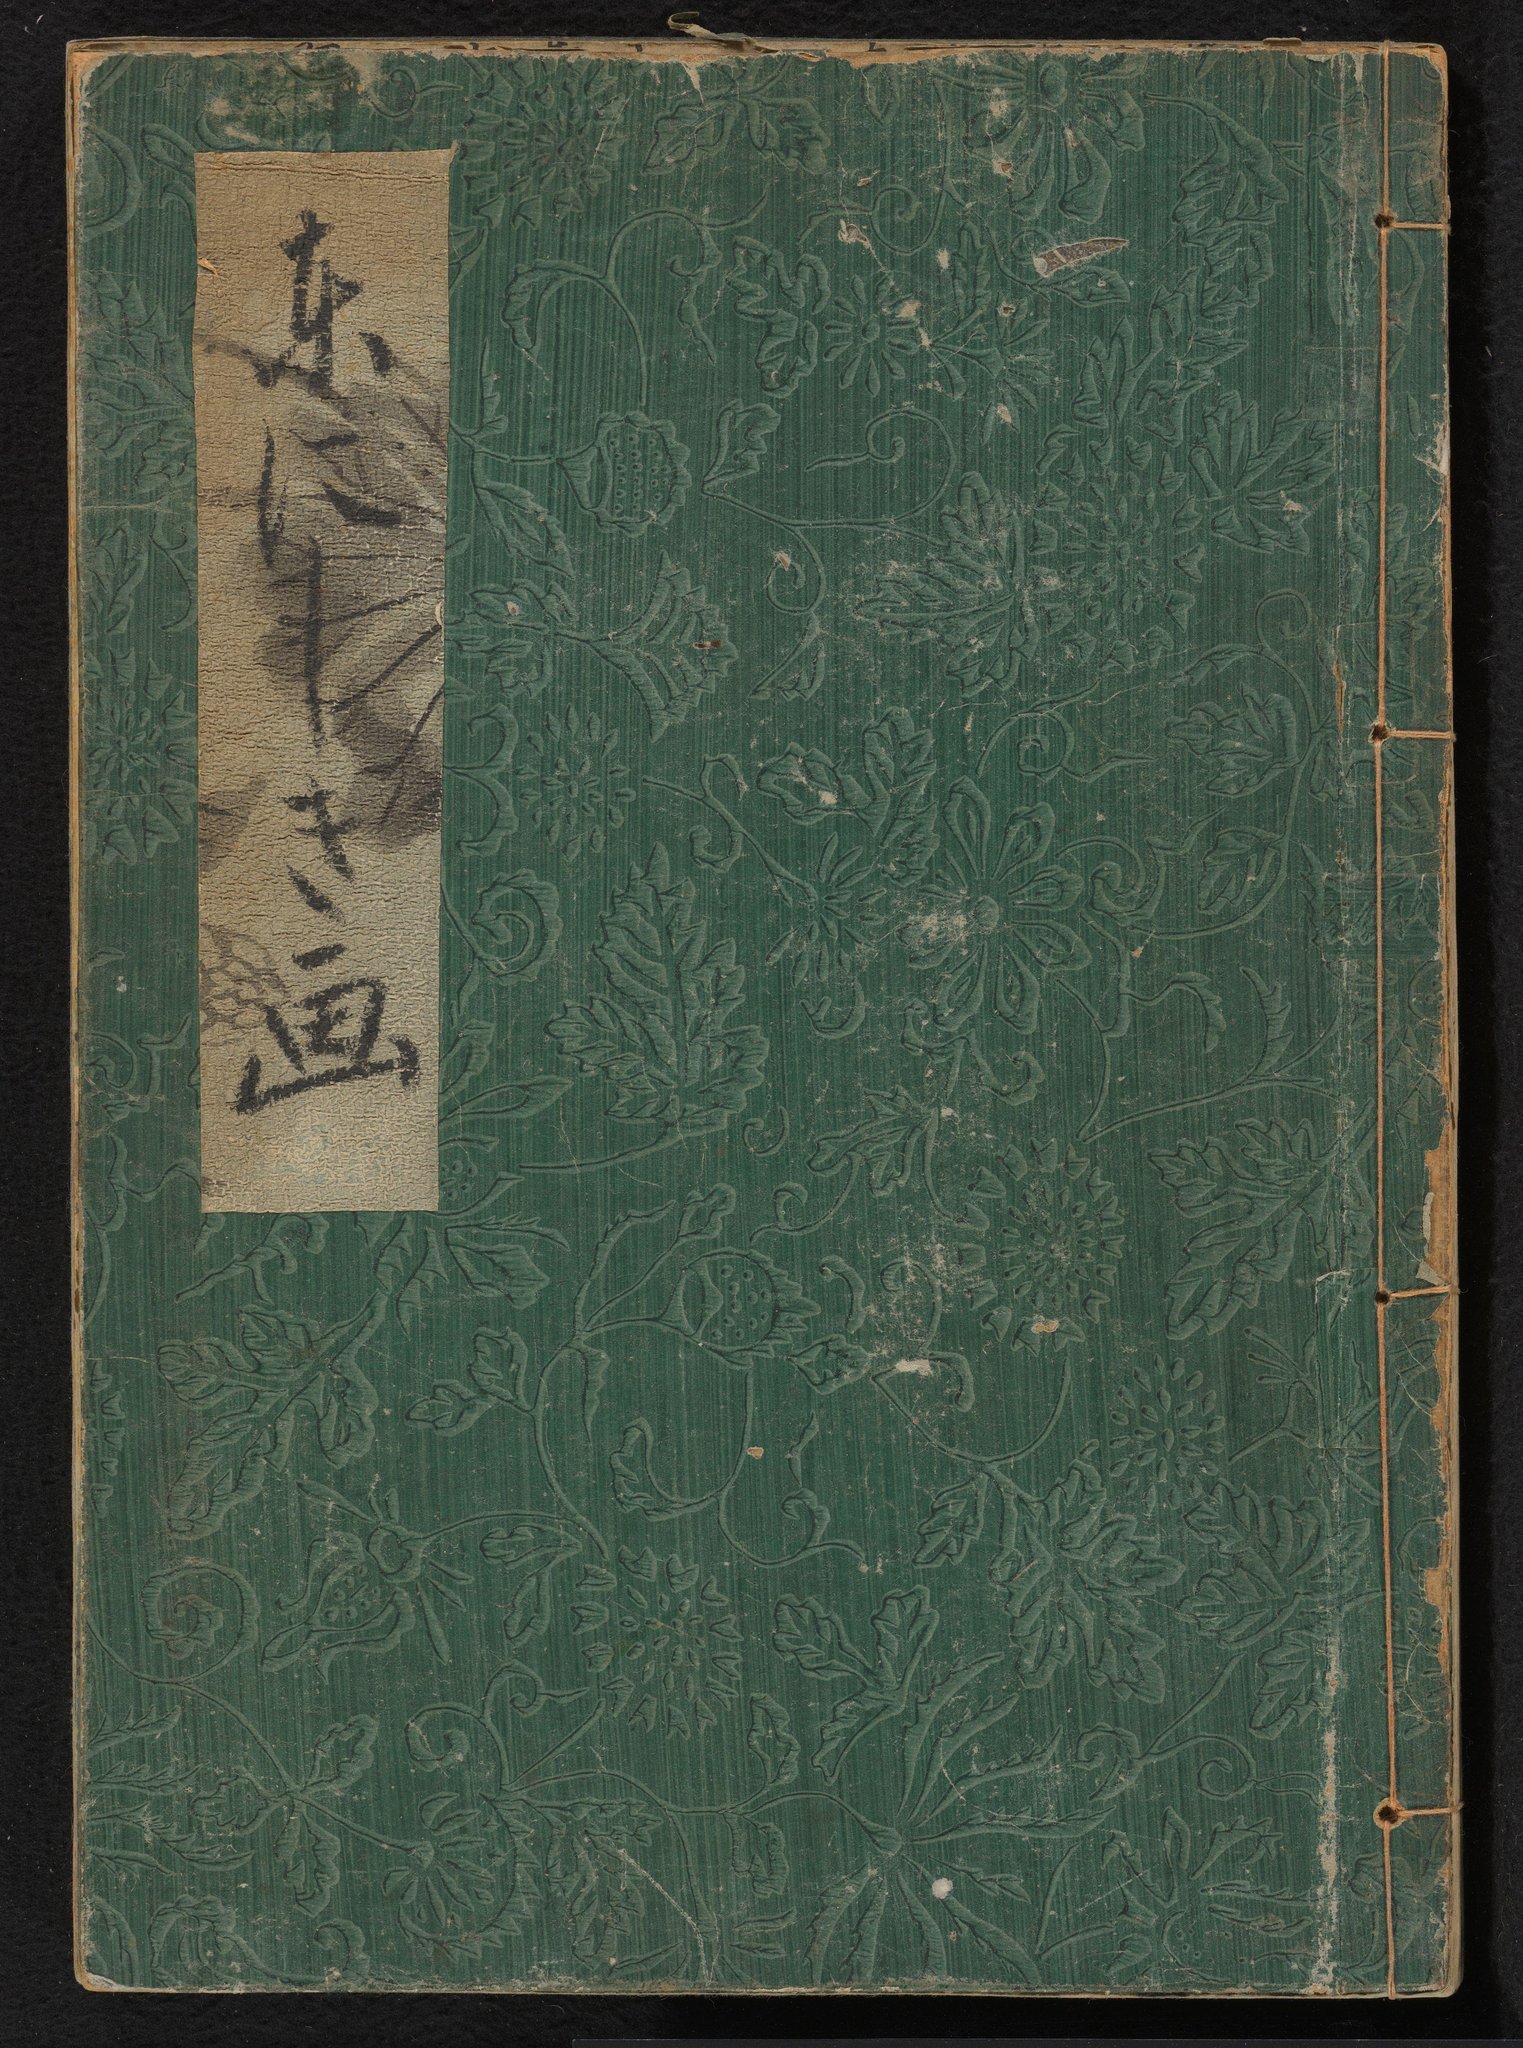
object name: prentrecueil, prentenalbum, prentalbum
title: Album met acteursprenten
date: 1800-1900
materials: paper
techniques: woodcut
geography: japan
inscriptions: label: ‘exlibris F.G. Waller Amsterdam 1893 fortior voluntas’, collector's mark: Lugt 2166